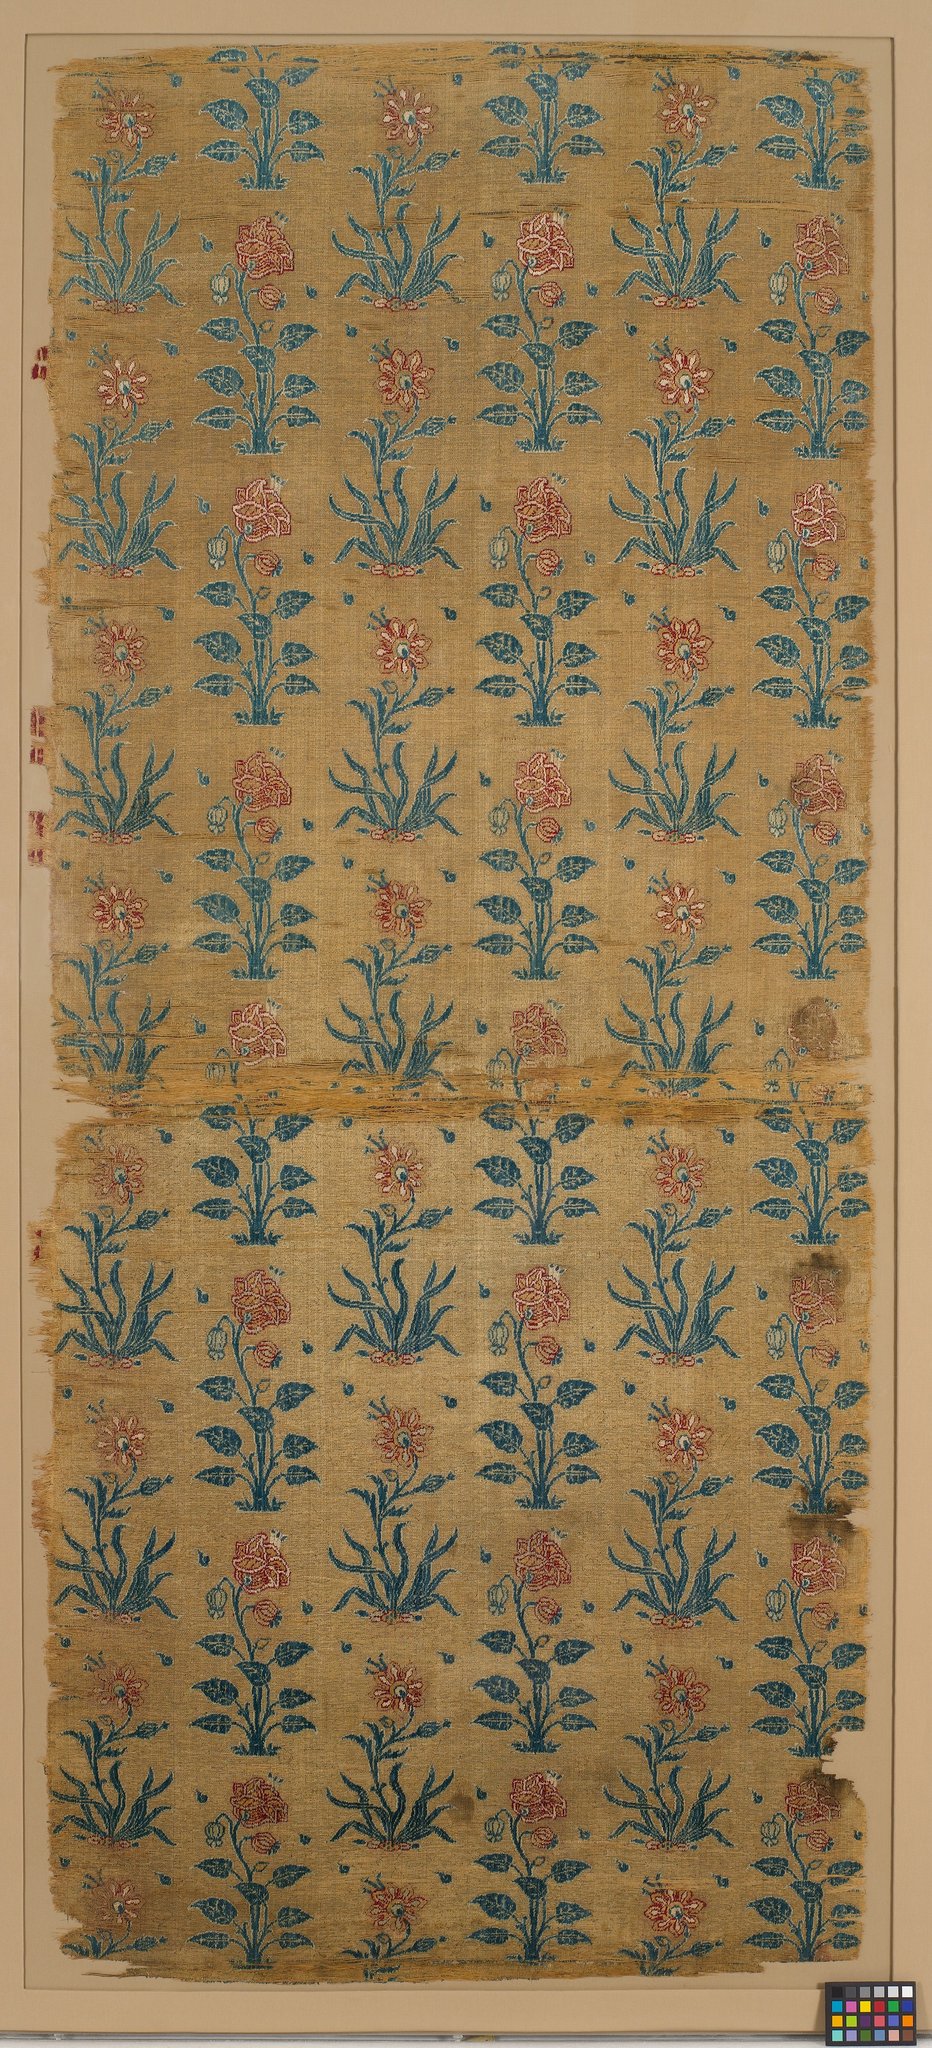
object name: joined fragment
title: Velvet Panel with Rows of Flowers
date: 1634-1666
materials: metal thread, silk, velvet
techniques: cutting, voiding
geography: india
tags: flowers,leaves